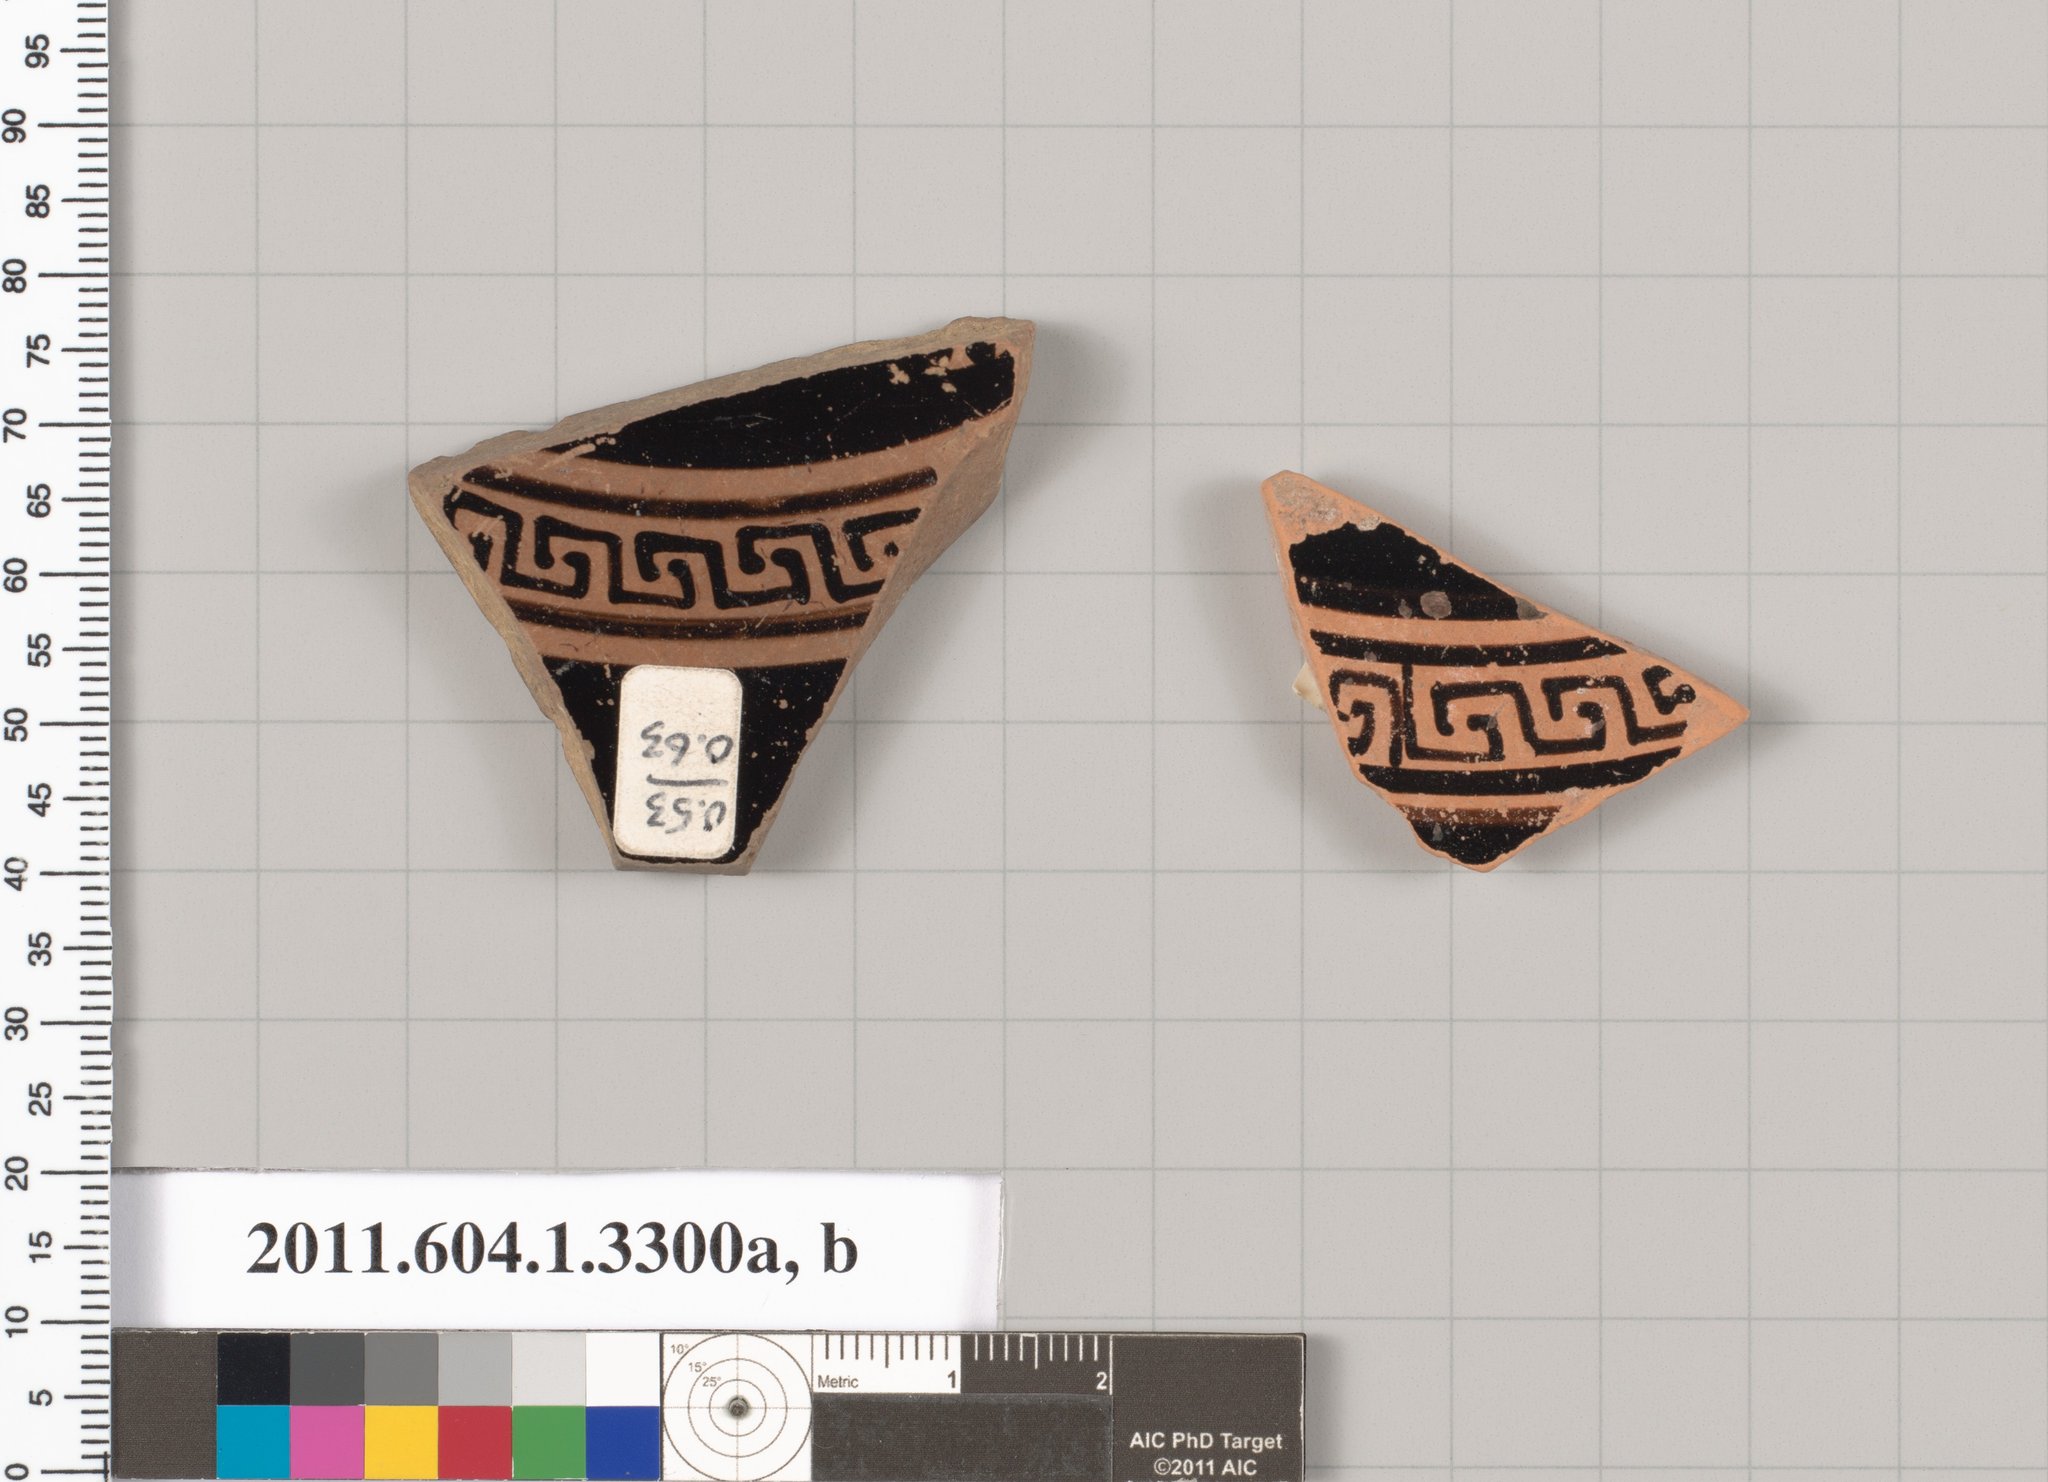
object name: kylix fragment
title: Terracotta fragments of kylikes (drinking cups)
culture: greek, attic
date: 500-480 BCE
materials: terracotta